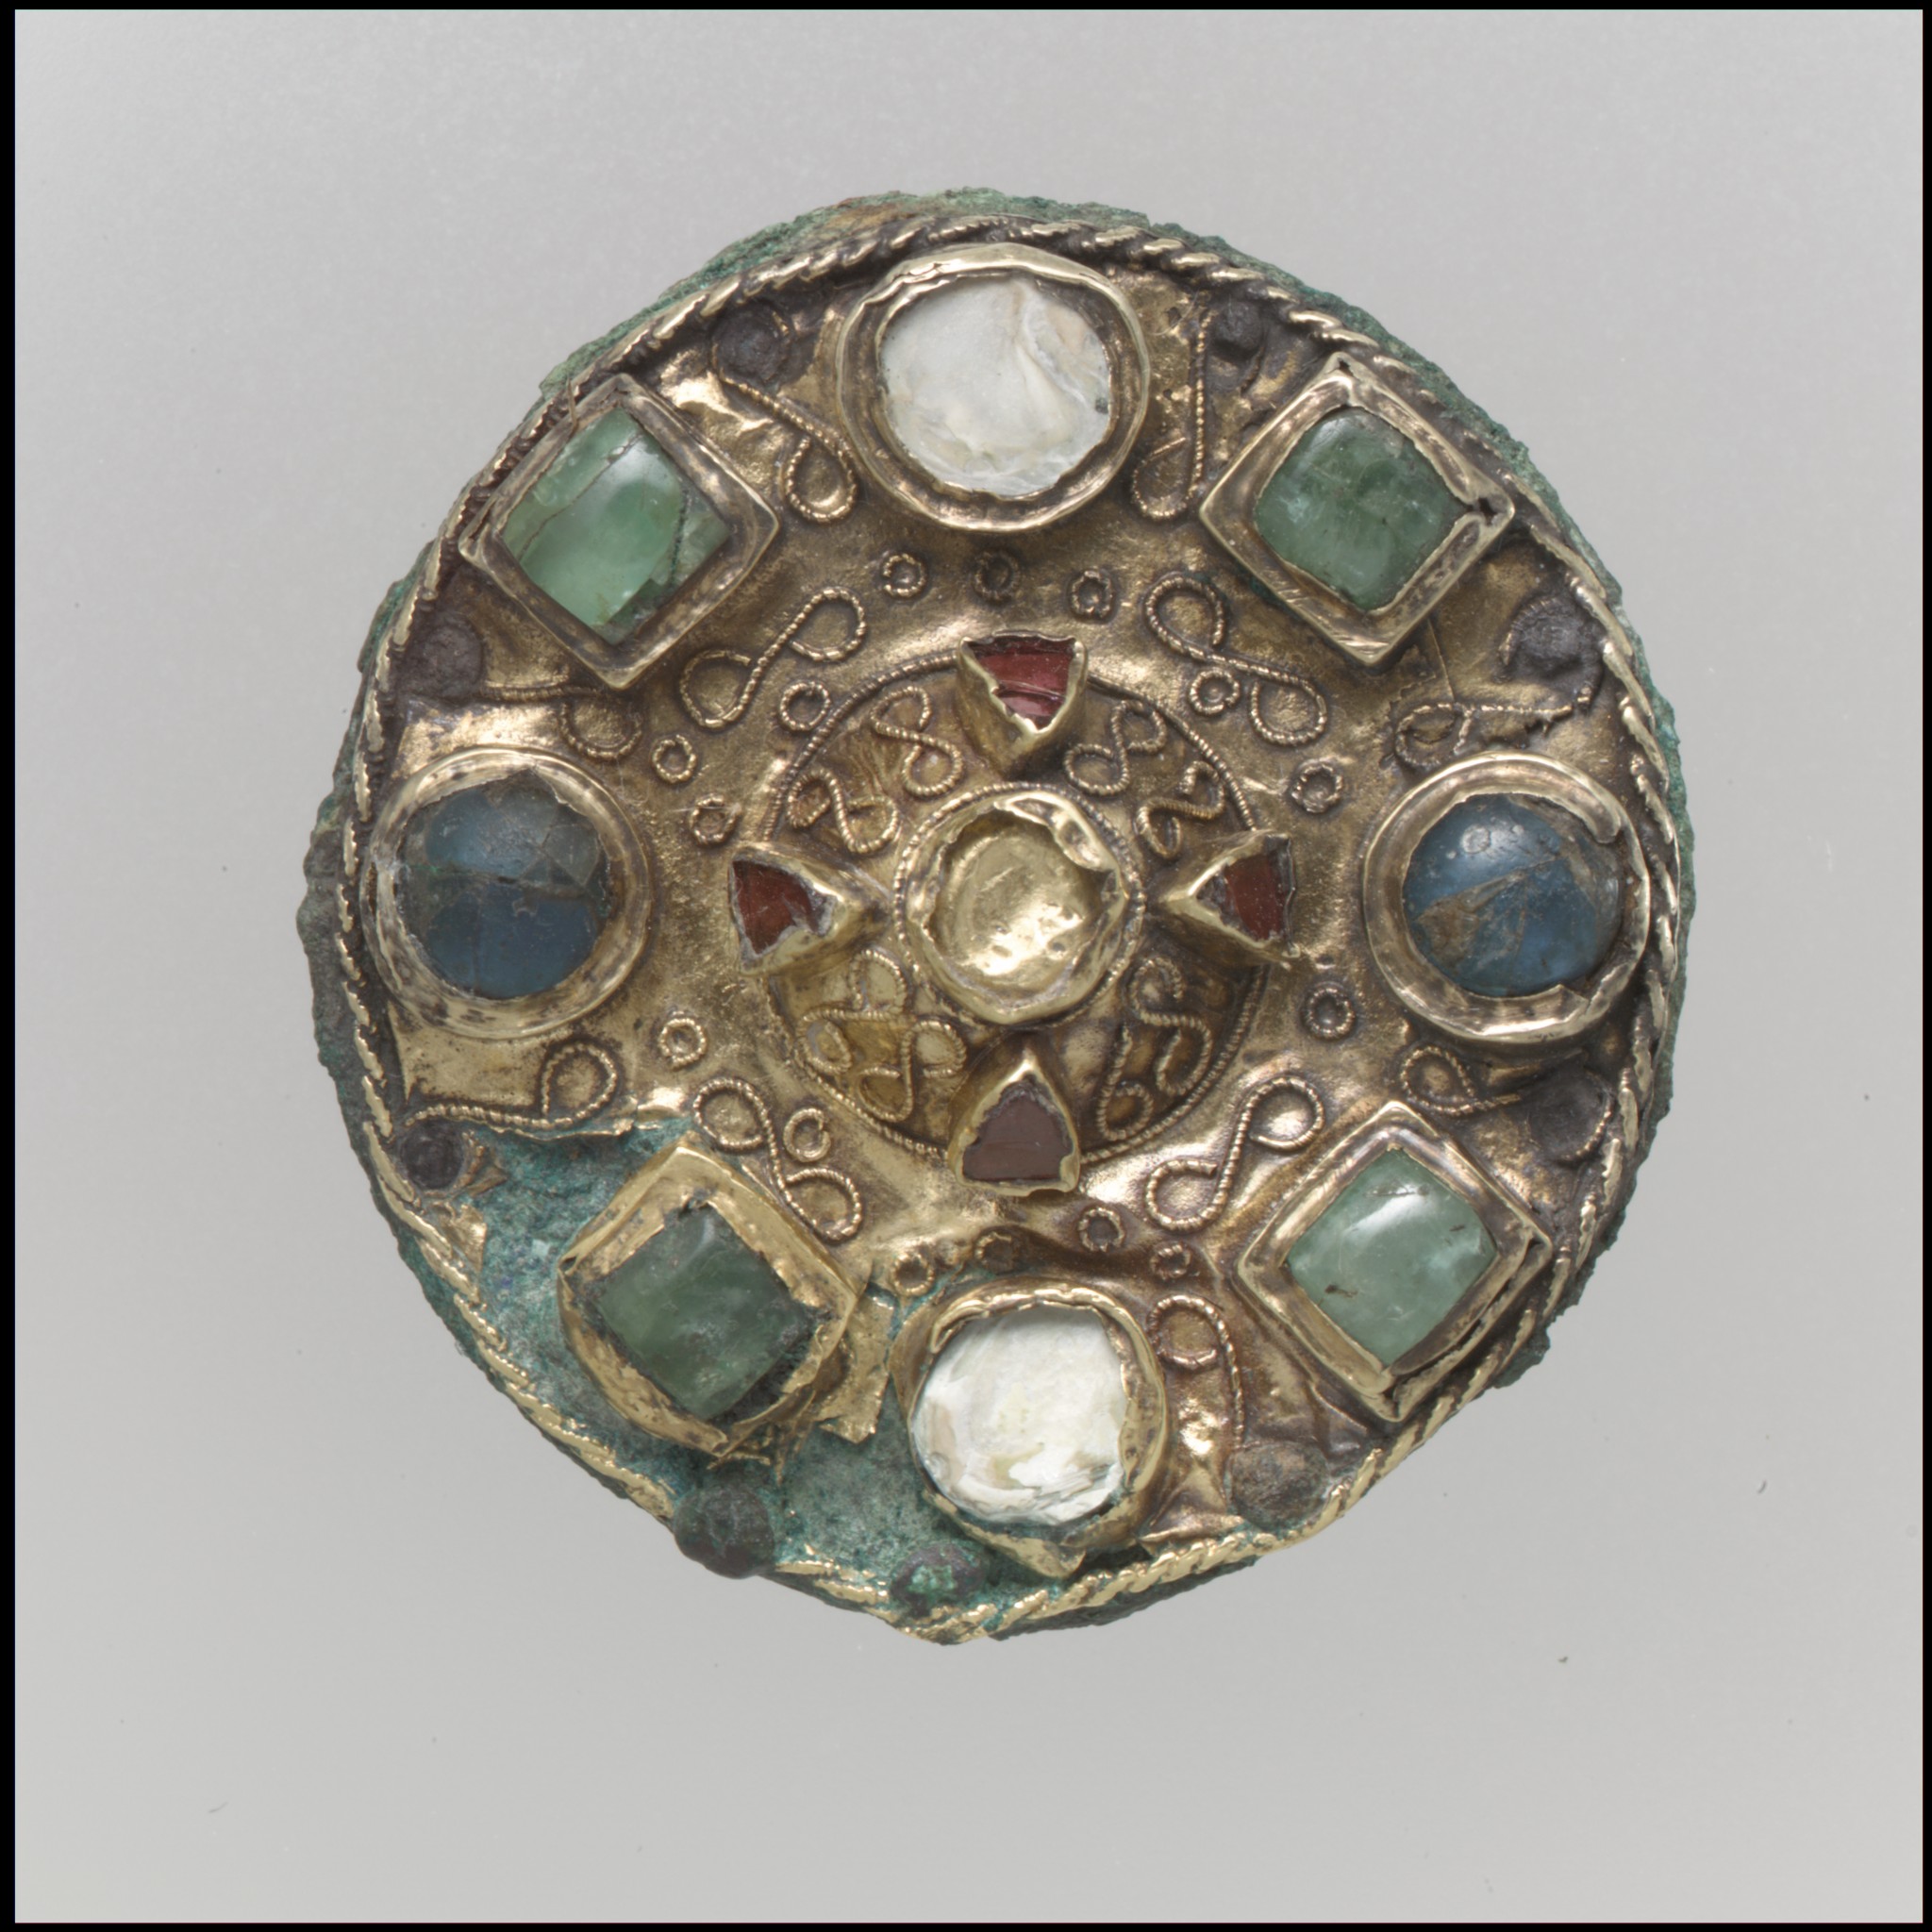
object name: brooch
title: Disk Brooch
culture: frankish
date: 601-700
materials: garnet, gold, mother of pearl, stone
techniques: filigree